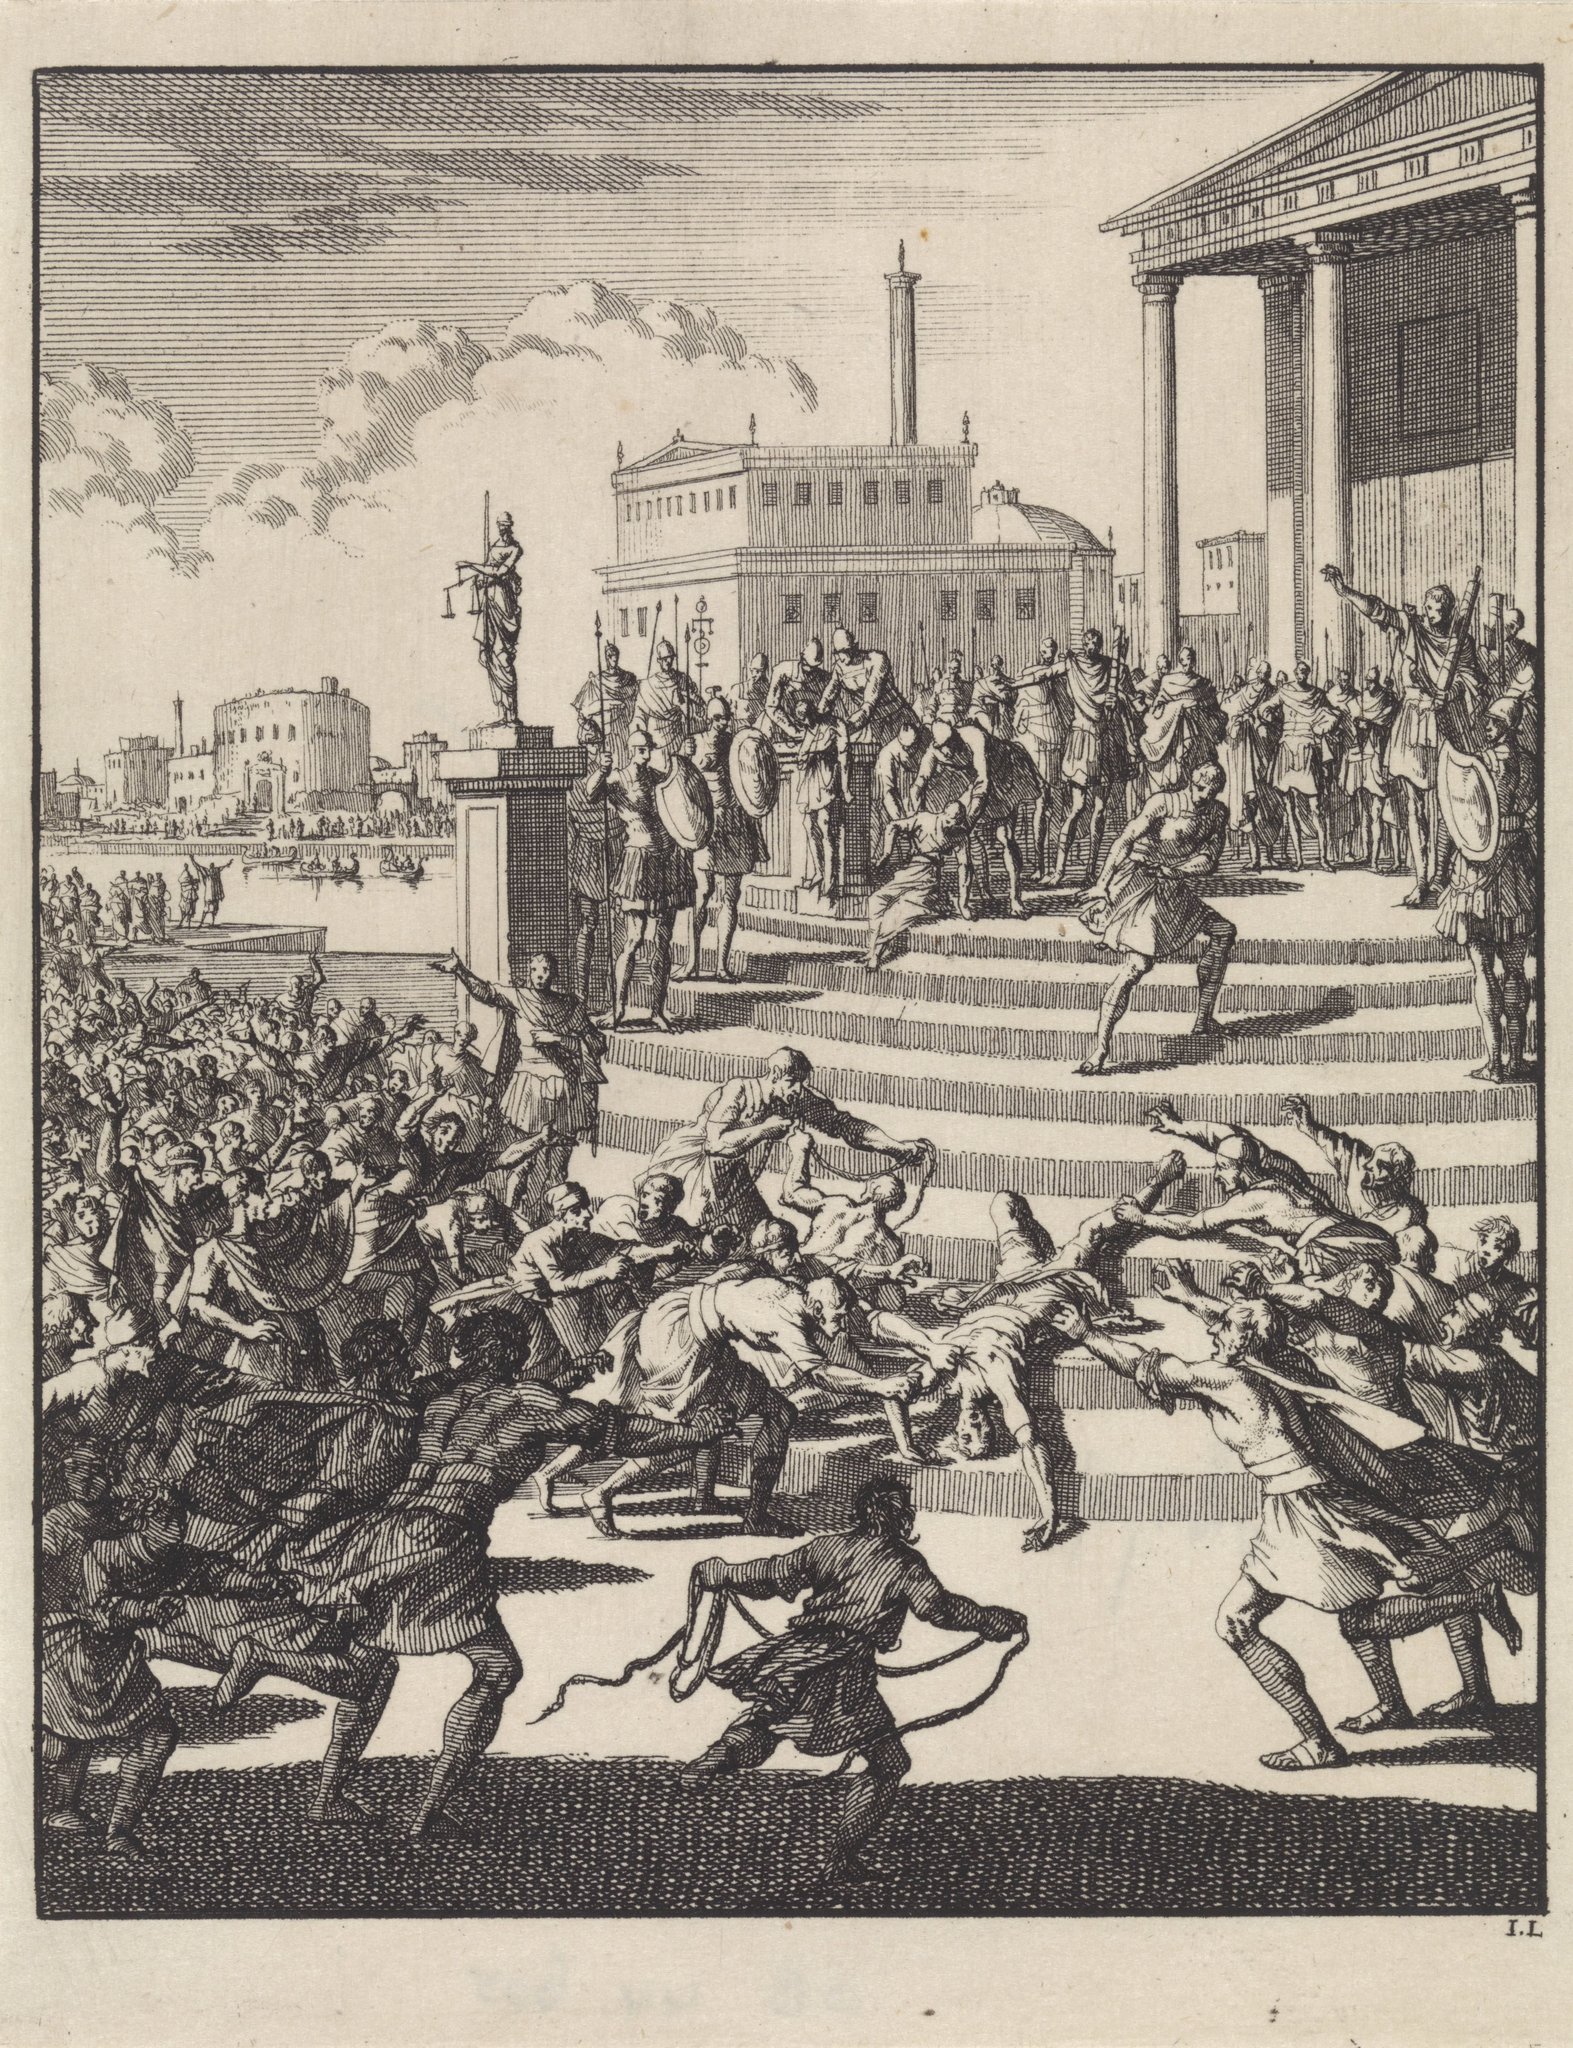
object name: print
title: Seianus, prefect onder keizer Tiberius, wordt mishandeld en gewurgd, 31 v.C.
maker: jan luyken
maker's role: draughtsman, print maker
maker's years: 1649-1712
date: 1698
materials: paper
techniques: etching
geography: amsterdam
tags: violent death, being killed; being mishandled and maltreated; seeking death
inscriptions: number: ‘5’, collector's mark: Lugt 2228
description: Proefdruk van illustratie uit: Bos, Lambert van den. Treur-toonneel der doorluchtige mannen, of Op- en ondergang der grooten, 3 delen. Amsterdam: Jan Claesz ten Hoorn, 1698, dl. I.